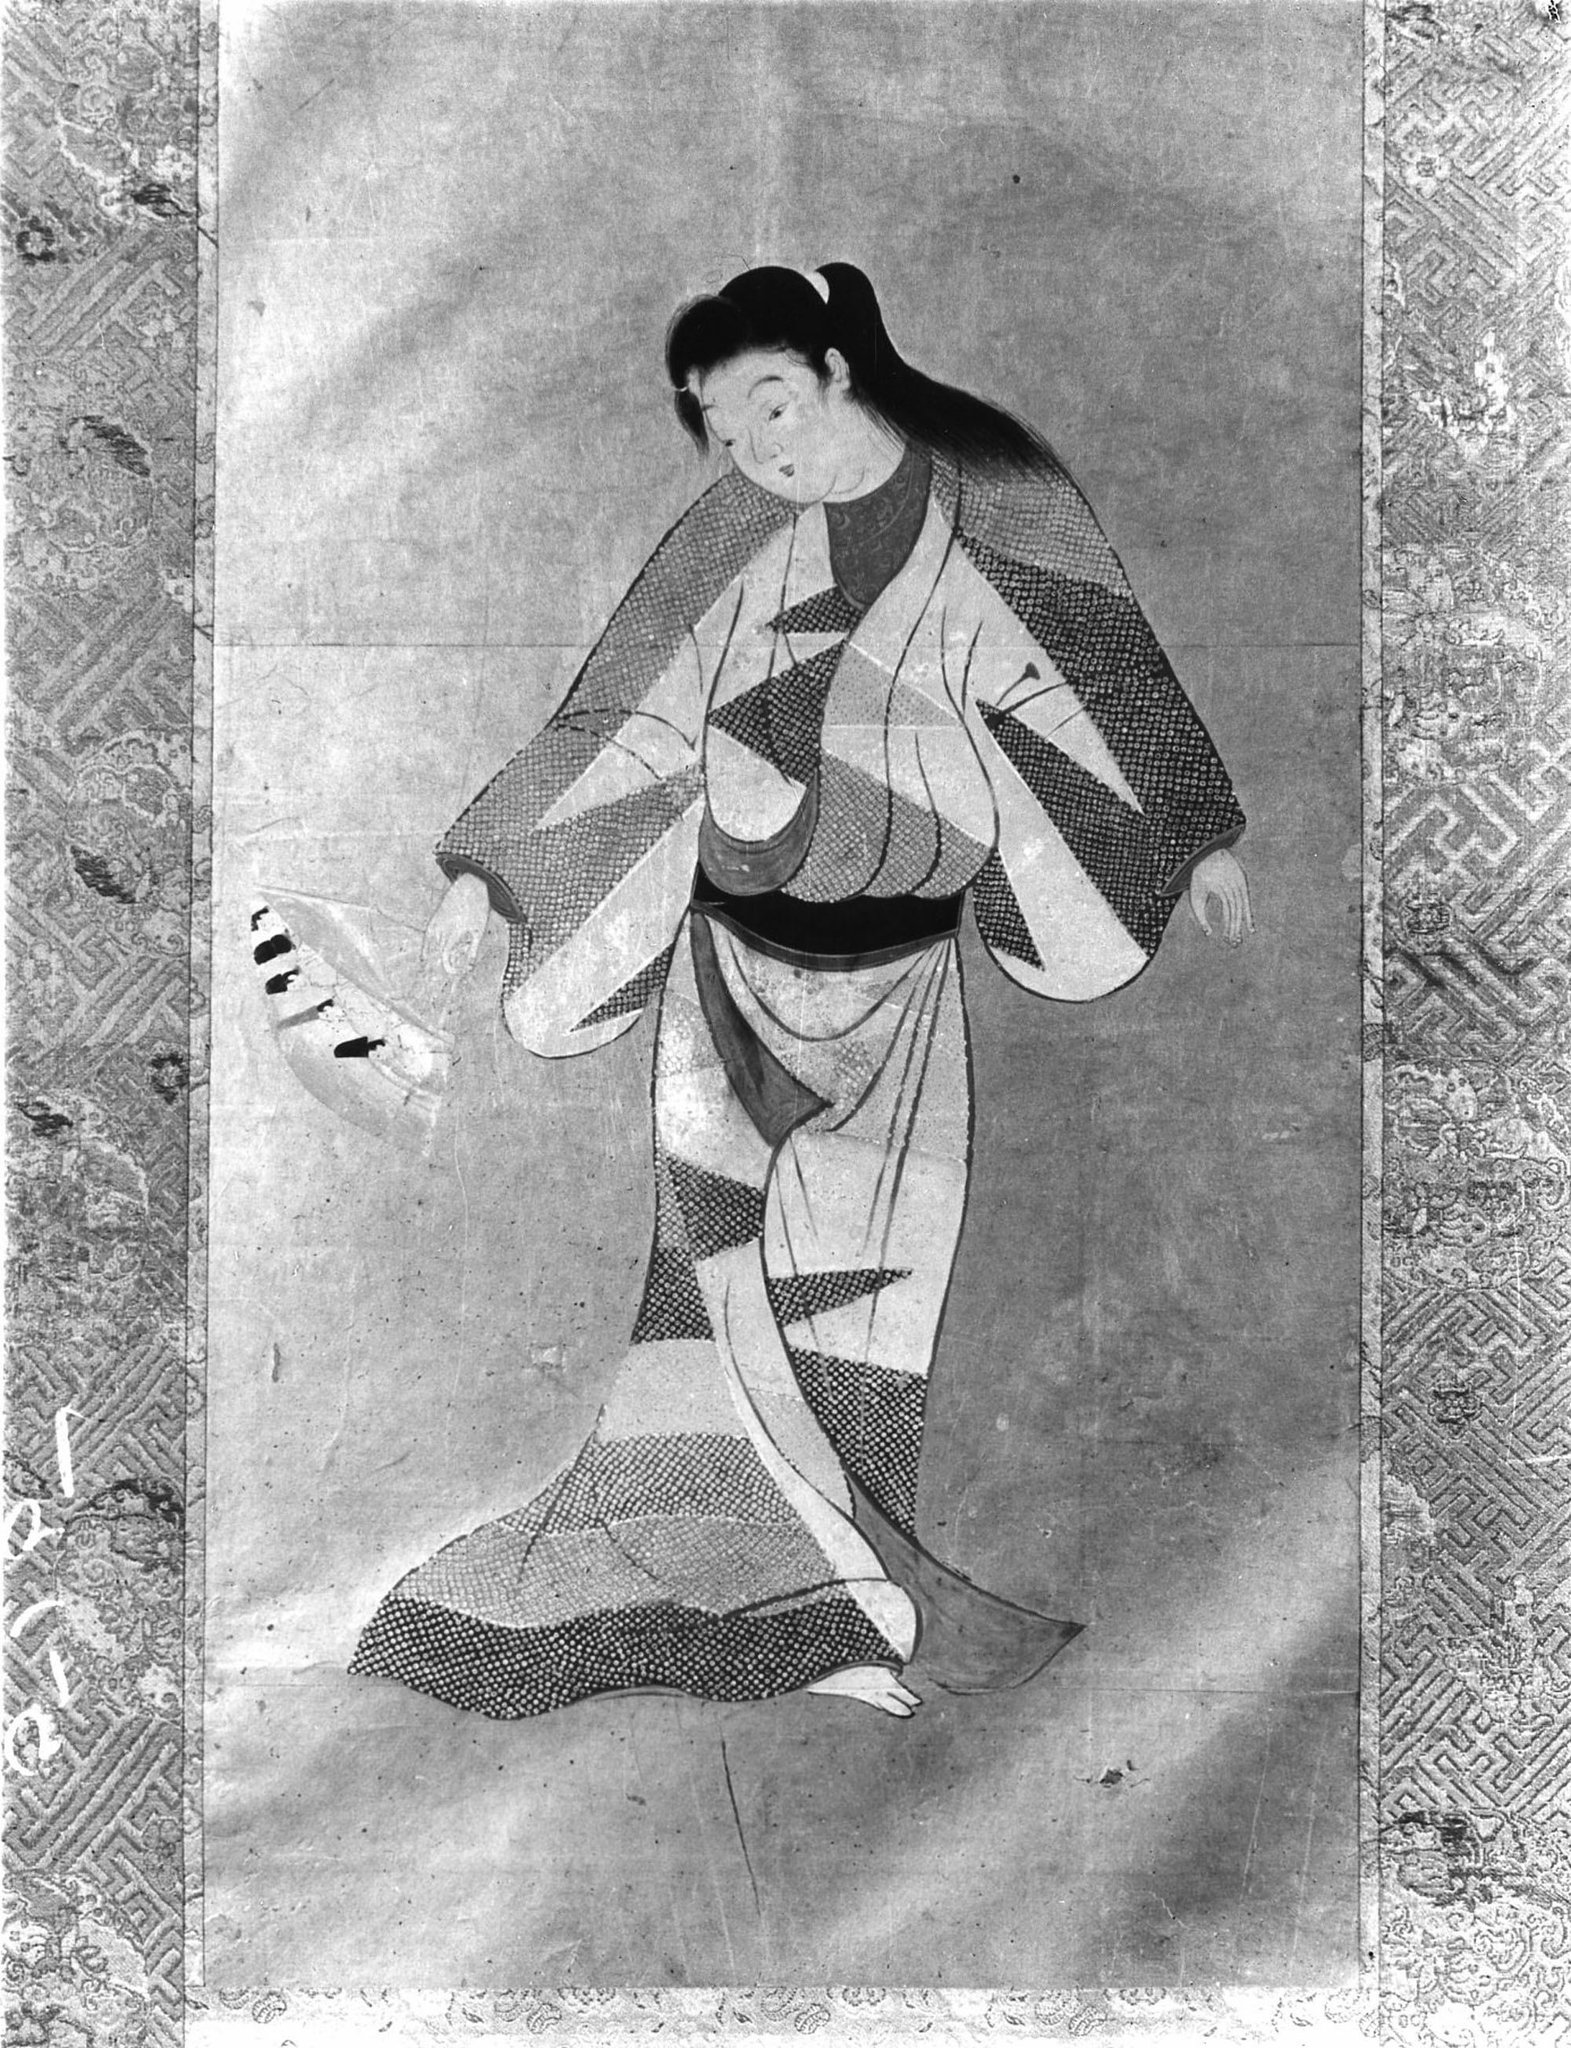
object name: hanging scroll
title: Female Dancer with a Fan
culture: japanese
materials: ink, paper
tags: fans,women,dancers